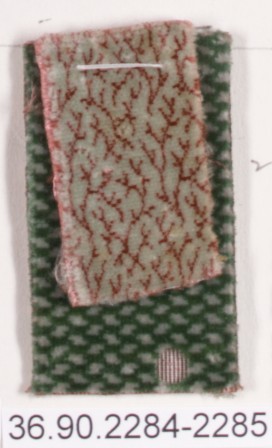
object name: piece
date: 1801-1900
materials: silk